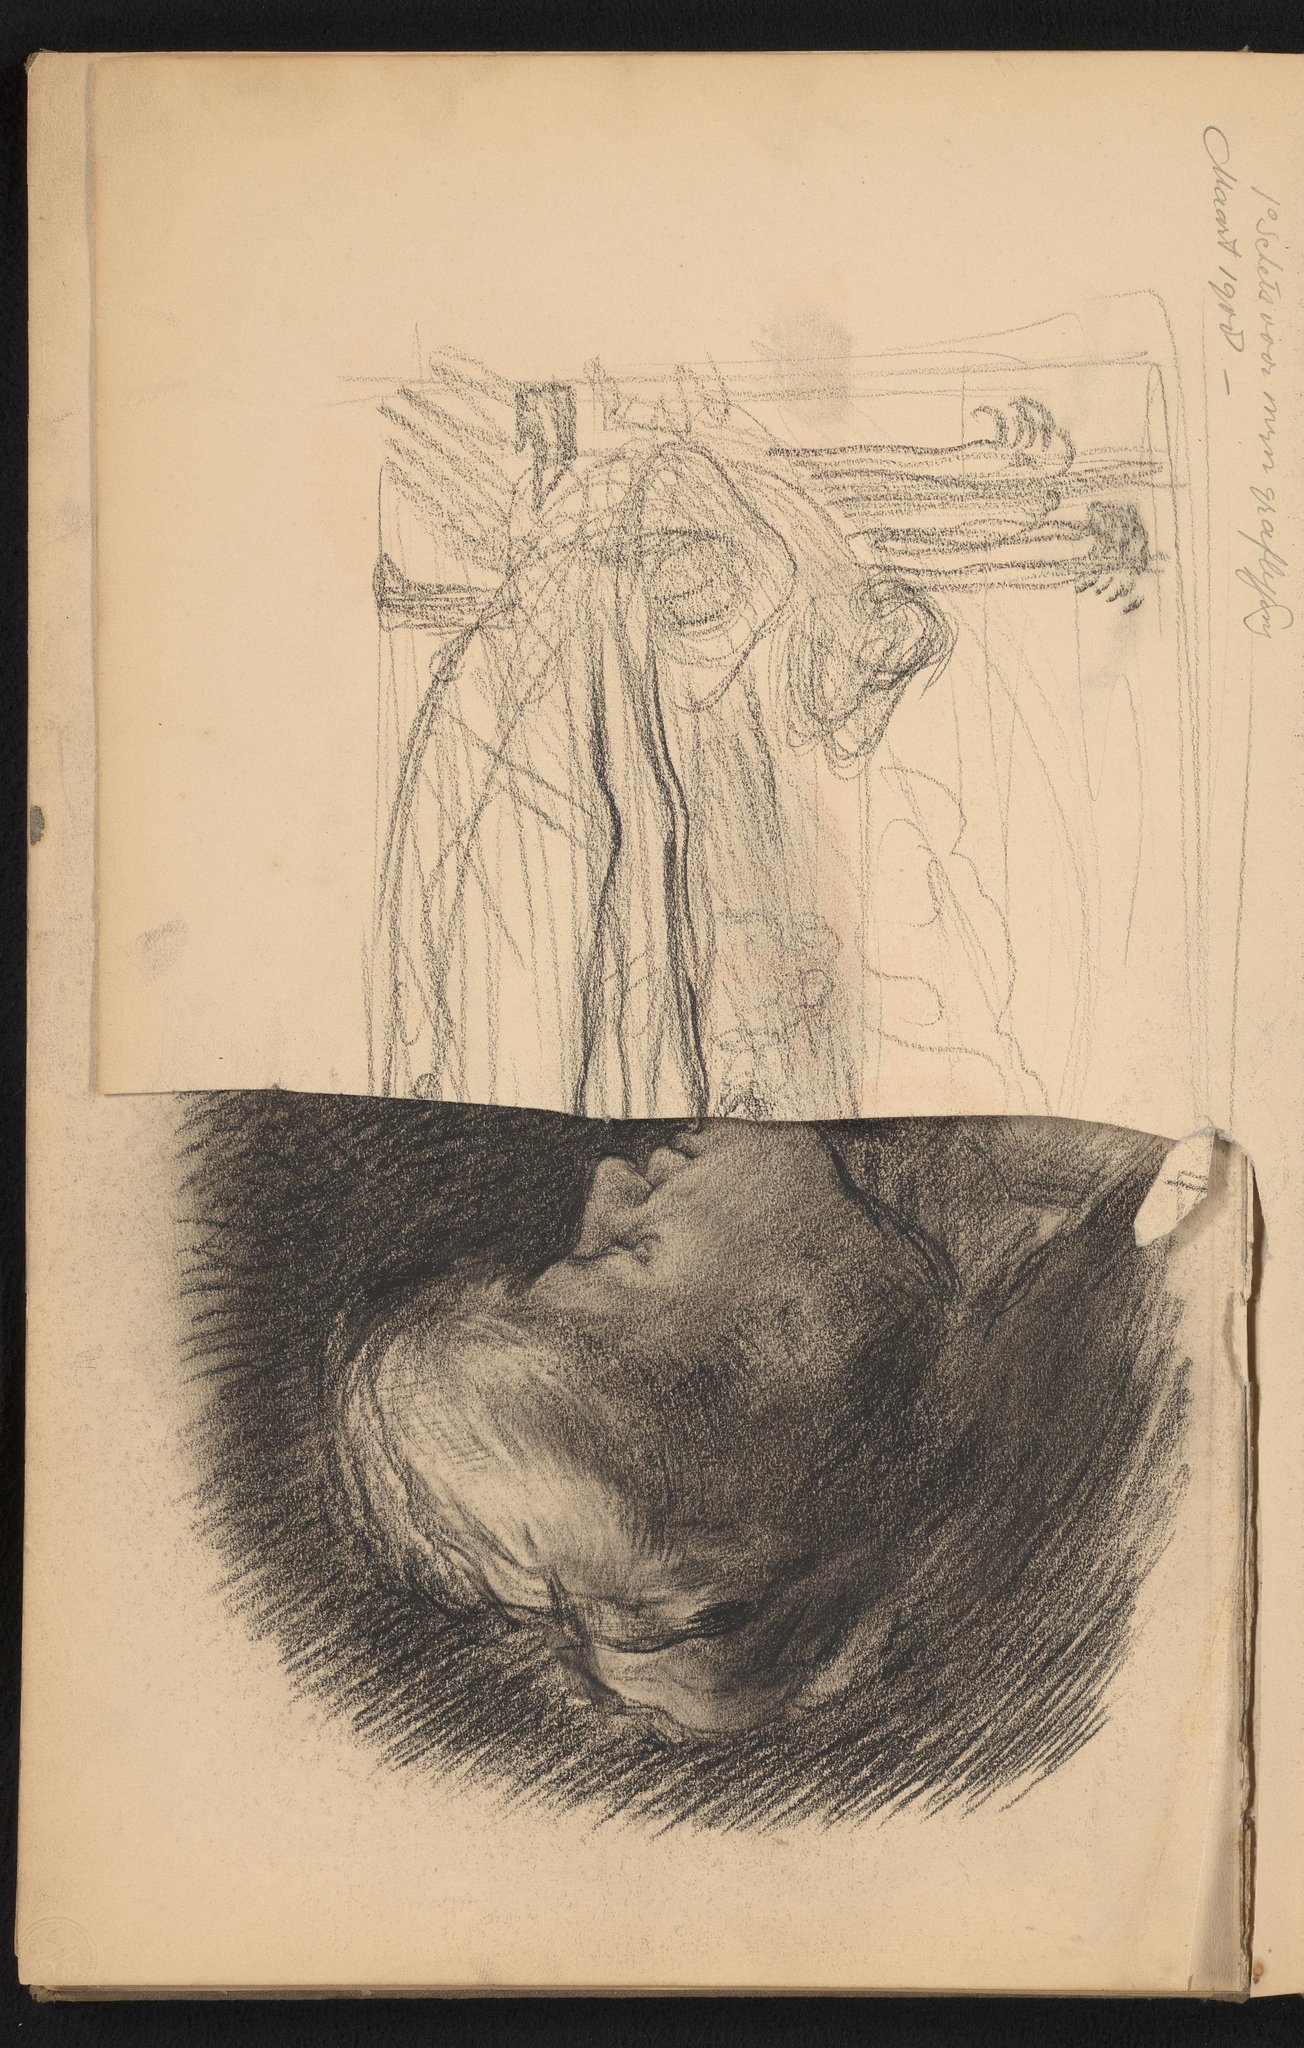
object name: sketchbook leaf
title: Graflegging van Christus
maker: huib luns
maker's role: draughtsman, print maker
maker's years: 1881-1942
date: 1903-1908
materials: chalk, paper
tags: christ's entombment (possibly by angels)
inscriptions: date and inscription: ‘1e schets voor mijn graflegging/ Maart 1908-’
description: Het blad is voor de helft uit het schetsboek geknipt.